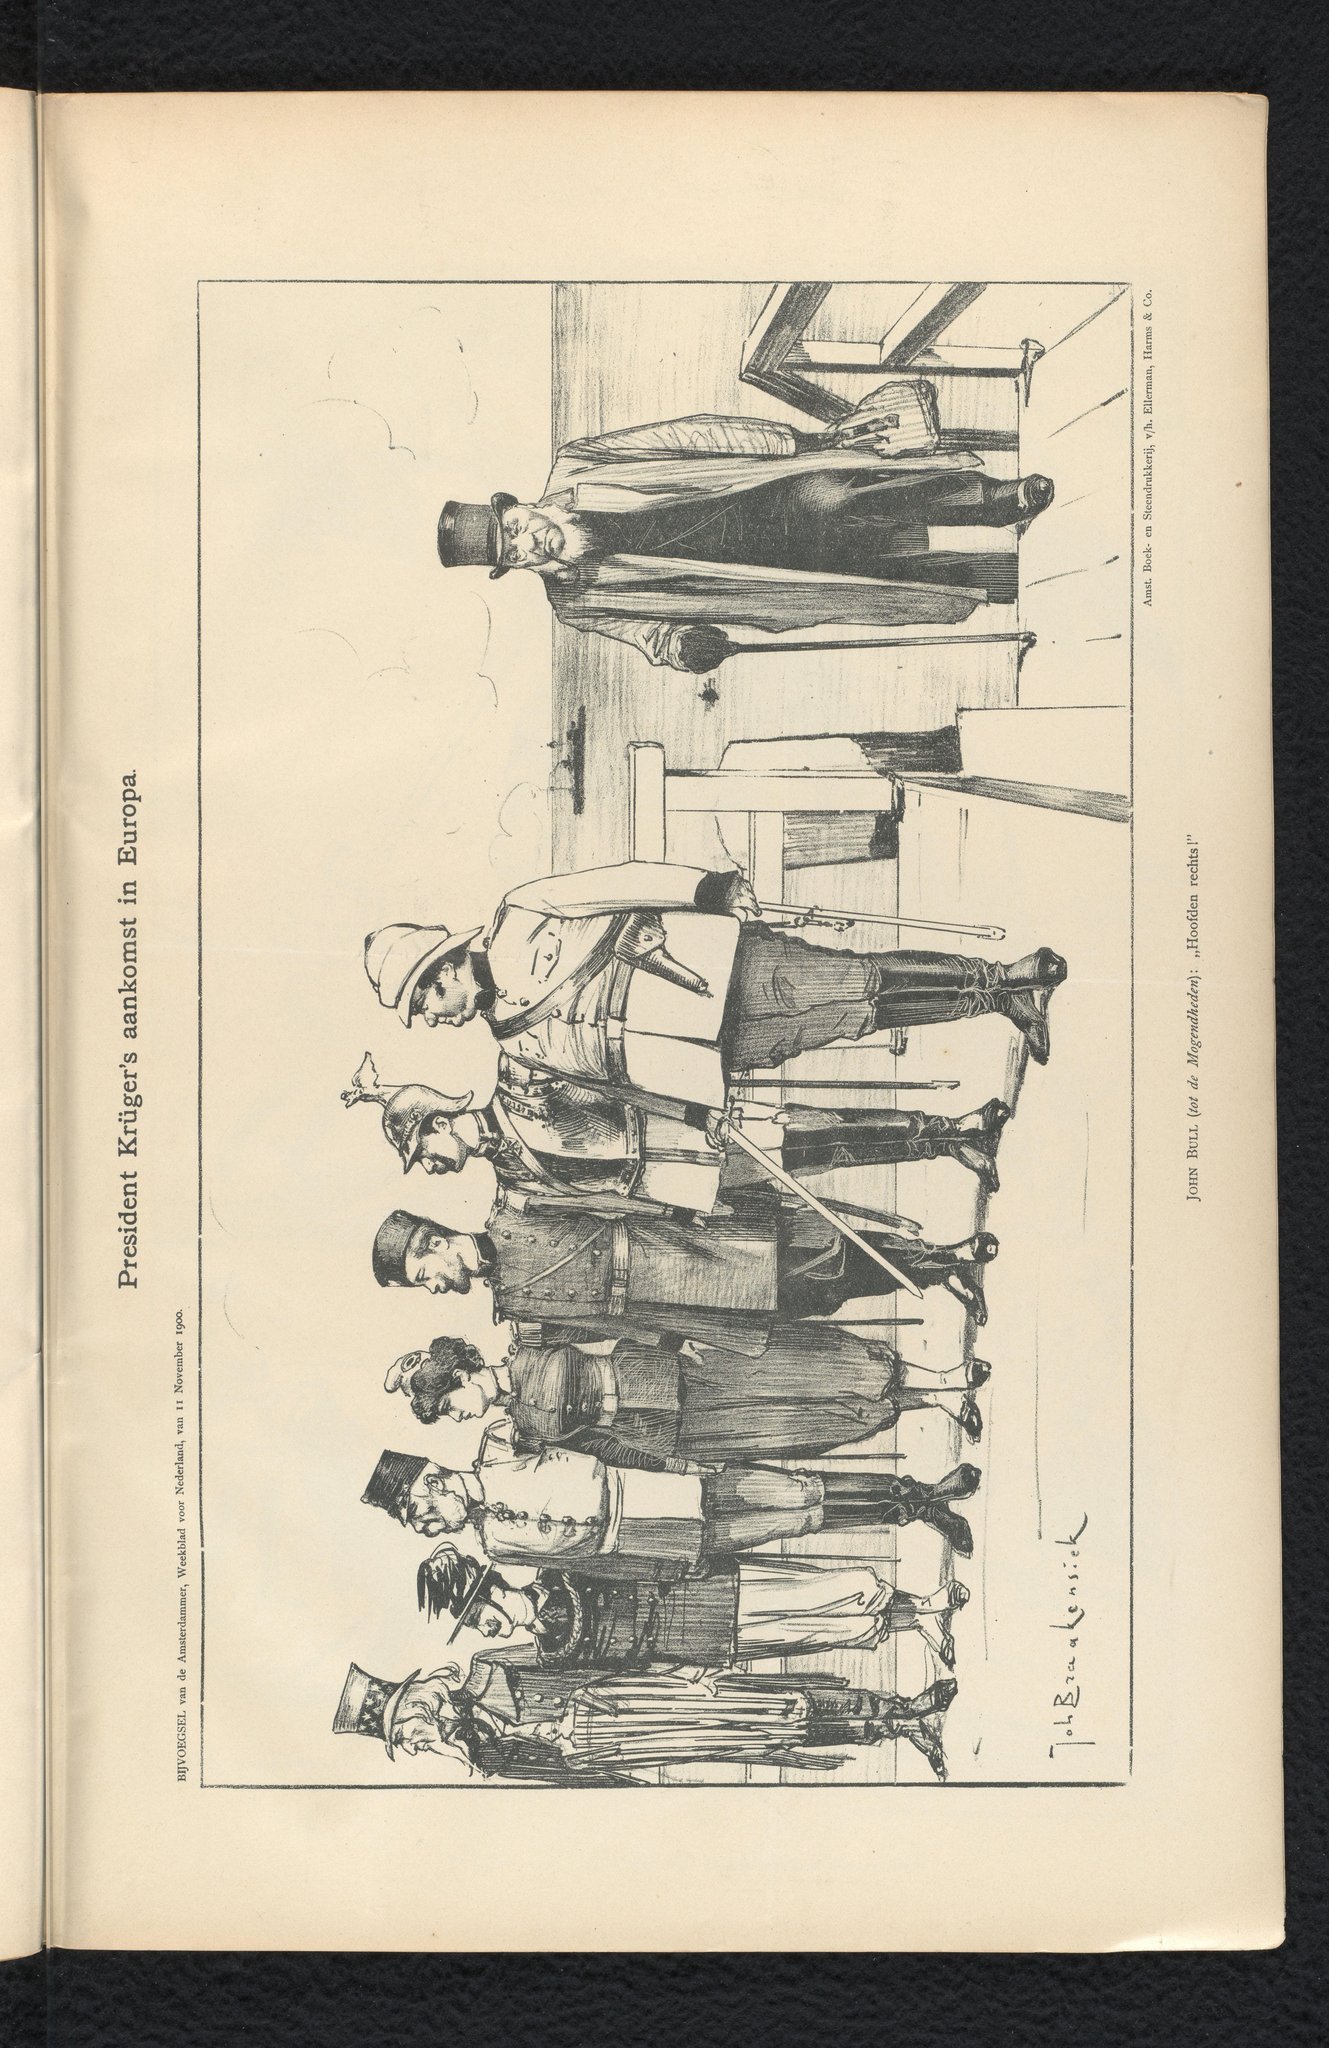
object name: cartoon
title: President Krüger's aankomst in Europa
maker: johan braakensiek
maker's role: draughtsman, print maker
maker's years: 1858-1940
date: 1900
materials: paper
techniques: lithograph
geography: netherlands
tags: vienna, wilhelm ii (keizer van duitsland), review, inspection (of company, unit, troop), personifications of countries, nations, states, districts, etc., political caricatures and satires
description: Als president Kruger de steiger oploopt wenden alle Westerse mogendheden en regeringsleiders hun hoofd van hem af. John Bull geeft instructies.